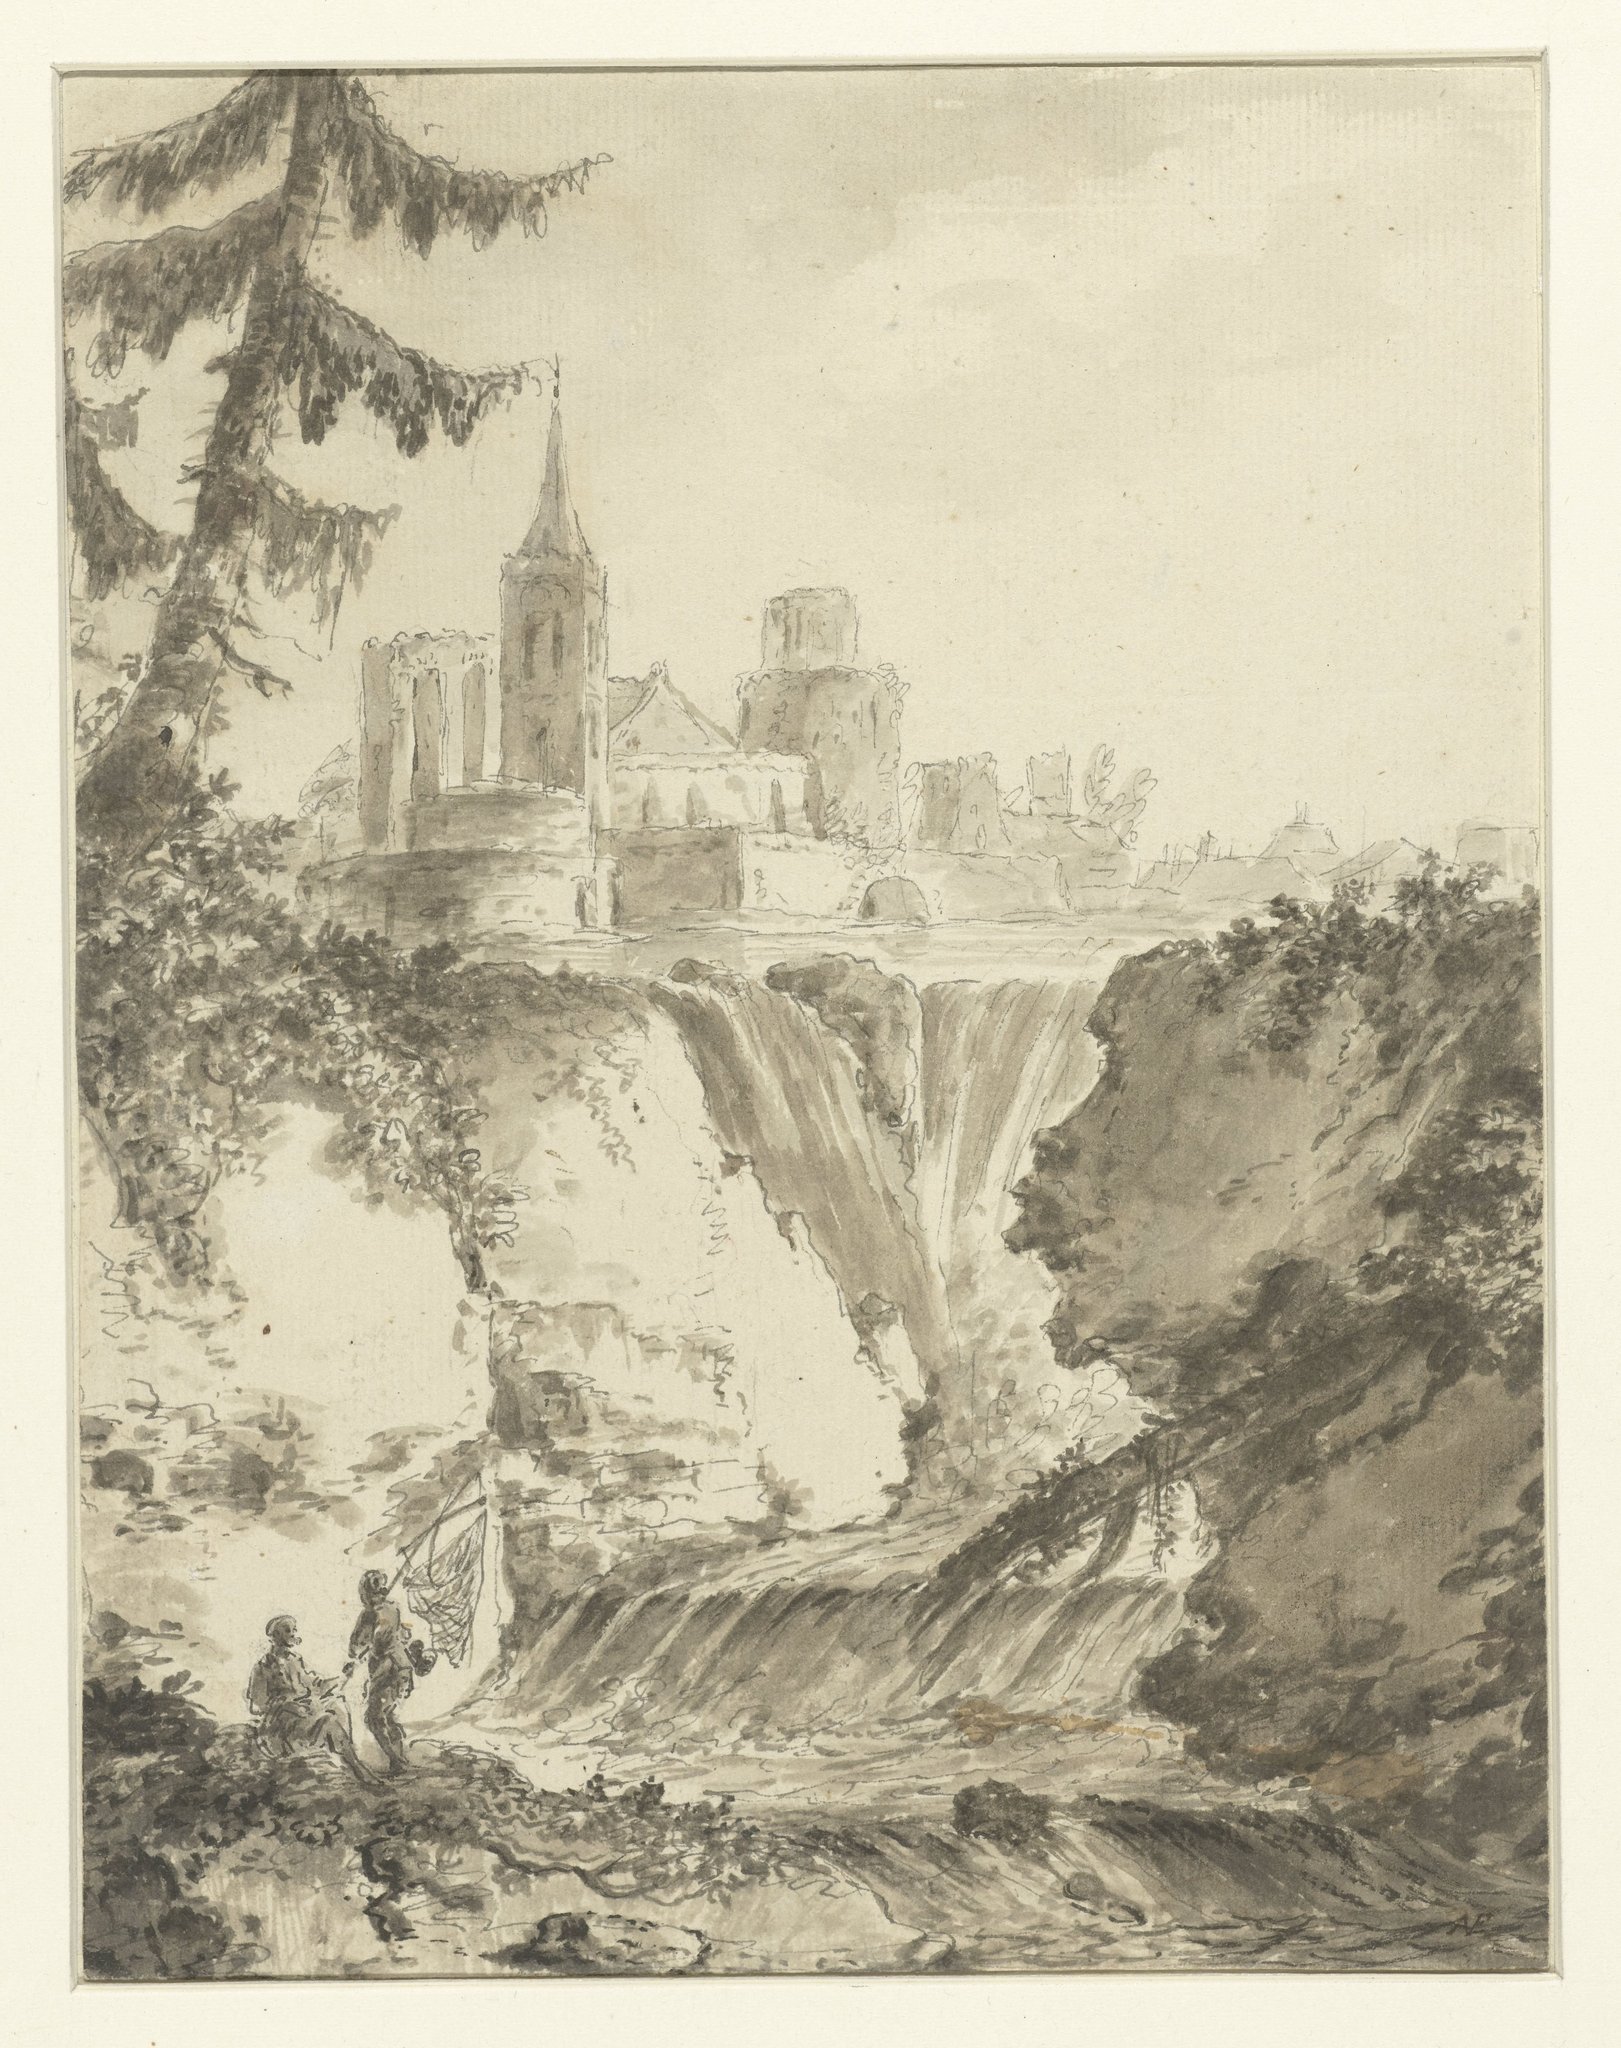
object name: drawing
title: Ruïneus kerkgebouw bij een waterval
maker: Anonymous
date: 1700-1800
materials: ink, paper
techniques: brush, pen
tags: waterfall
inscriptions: monogram, recto, lower right, pen and brown ink: ‘AE’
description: Ruïneus kerkgebouw bij een waterval, linksonderaan twee vissers.